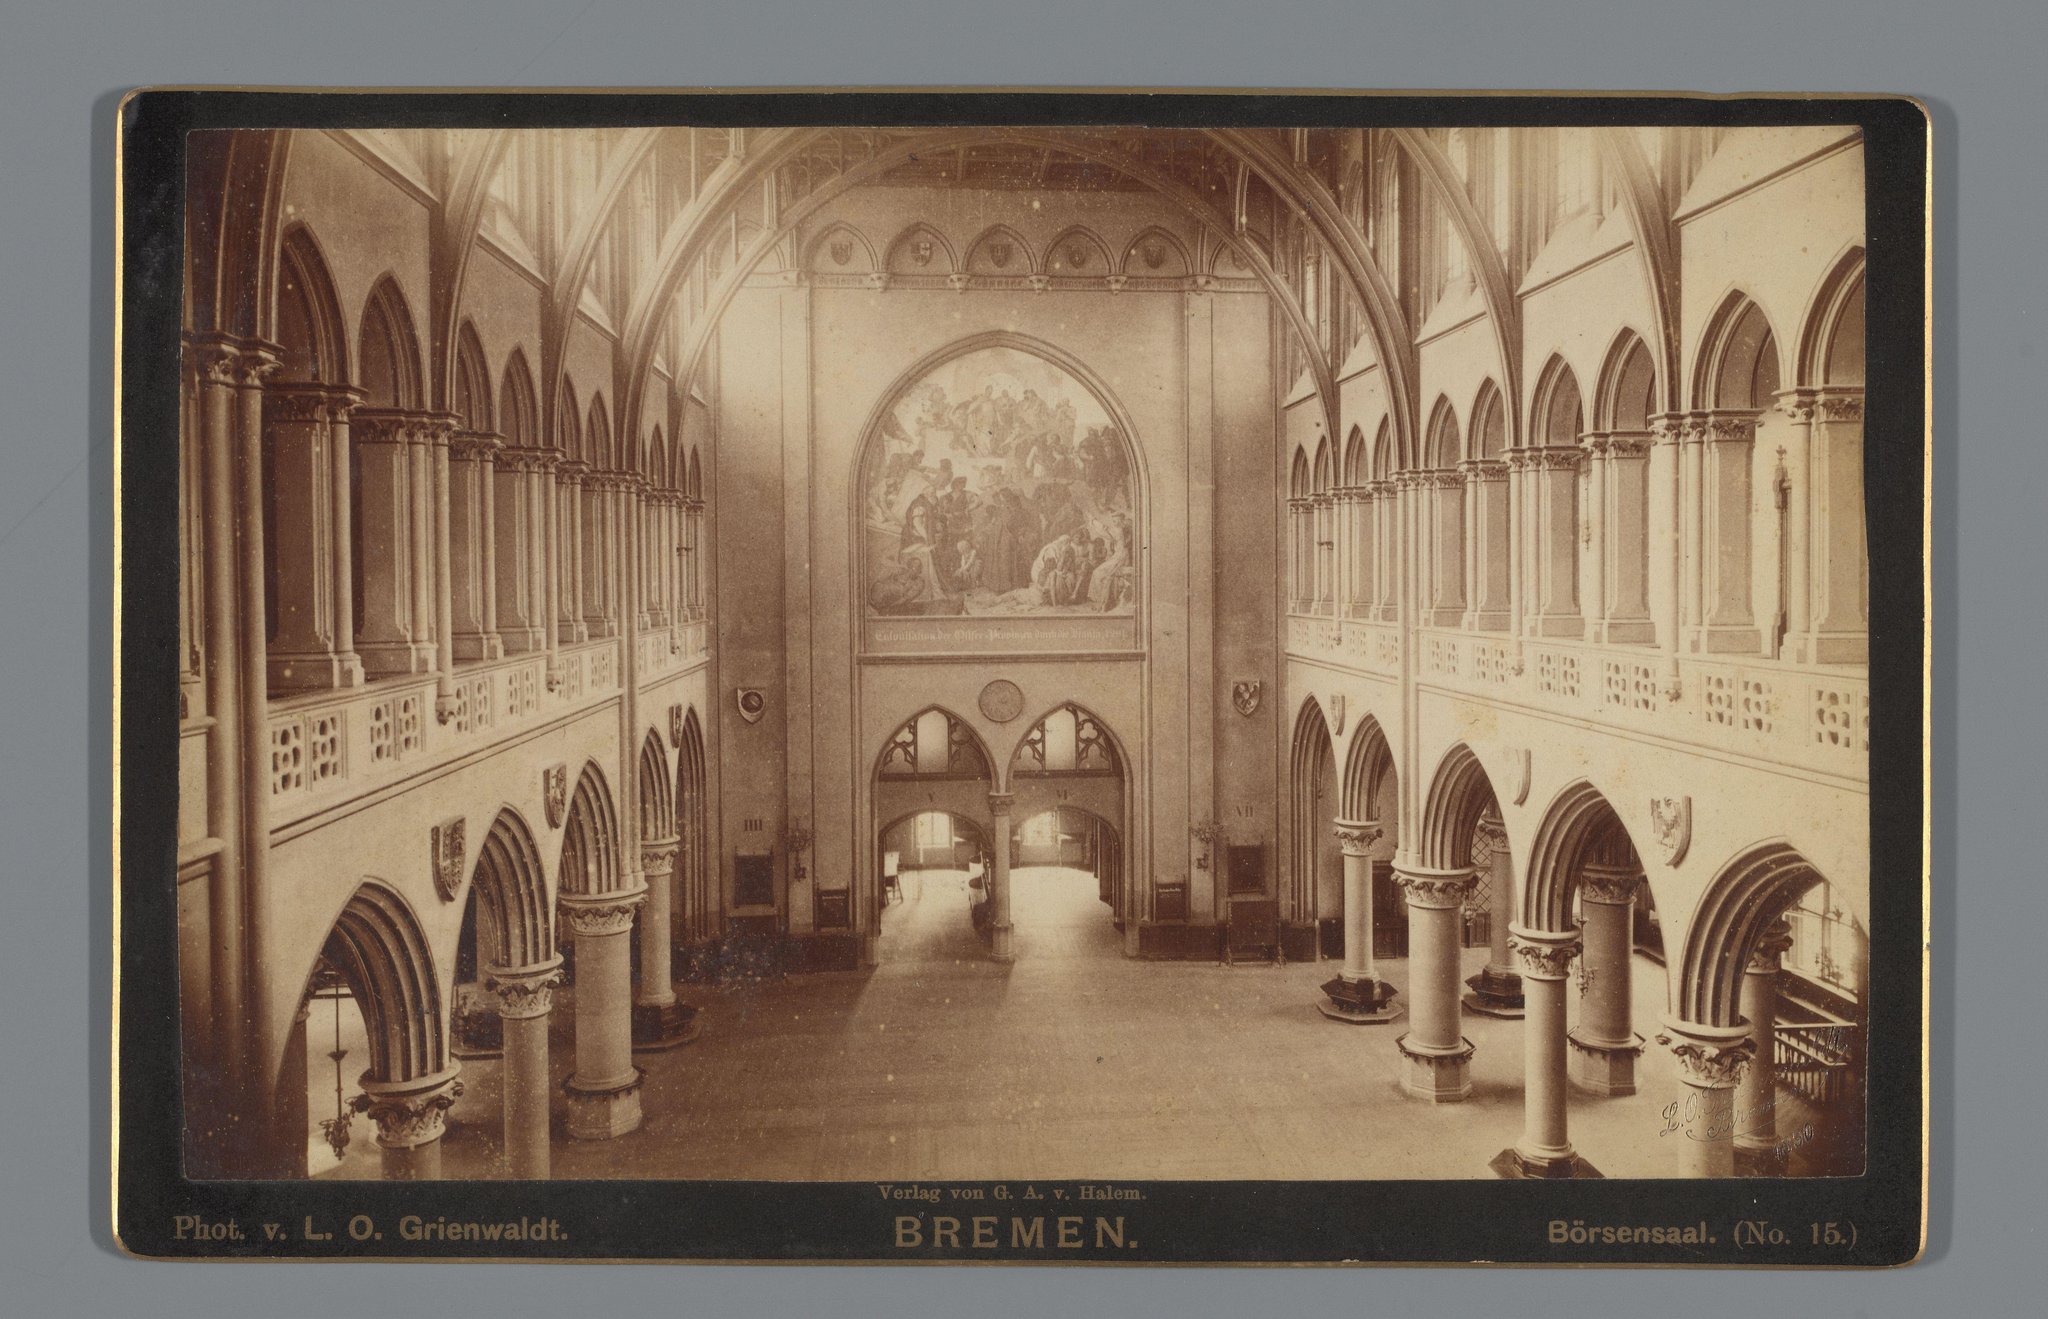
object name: photograph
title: Gezicht op de Börsensaal in de Beurs van Bremen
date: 1890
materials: cardboard, photographic support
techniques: albumen print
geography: bremen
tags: other rooms, exchange, bourse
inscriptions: inscription: ‘L.O. Grienwaldt/ Bremen/ 1890’, inscription: ‘Börsensaal. (No. 15.)’